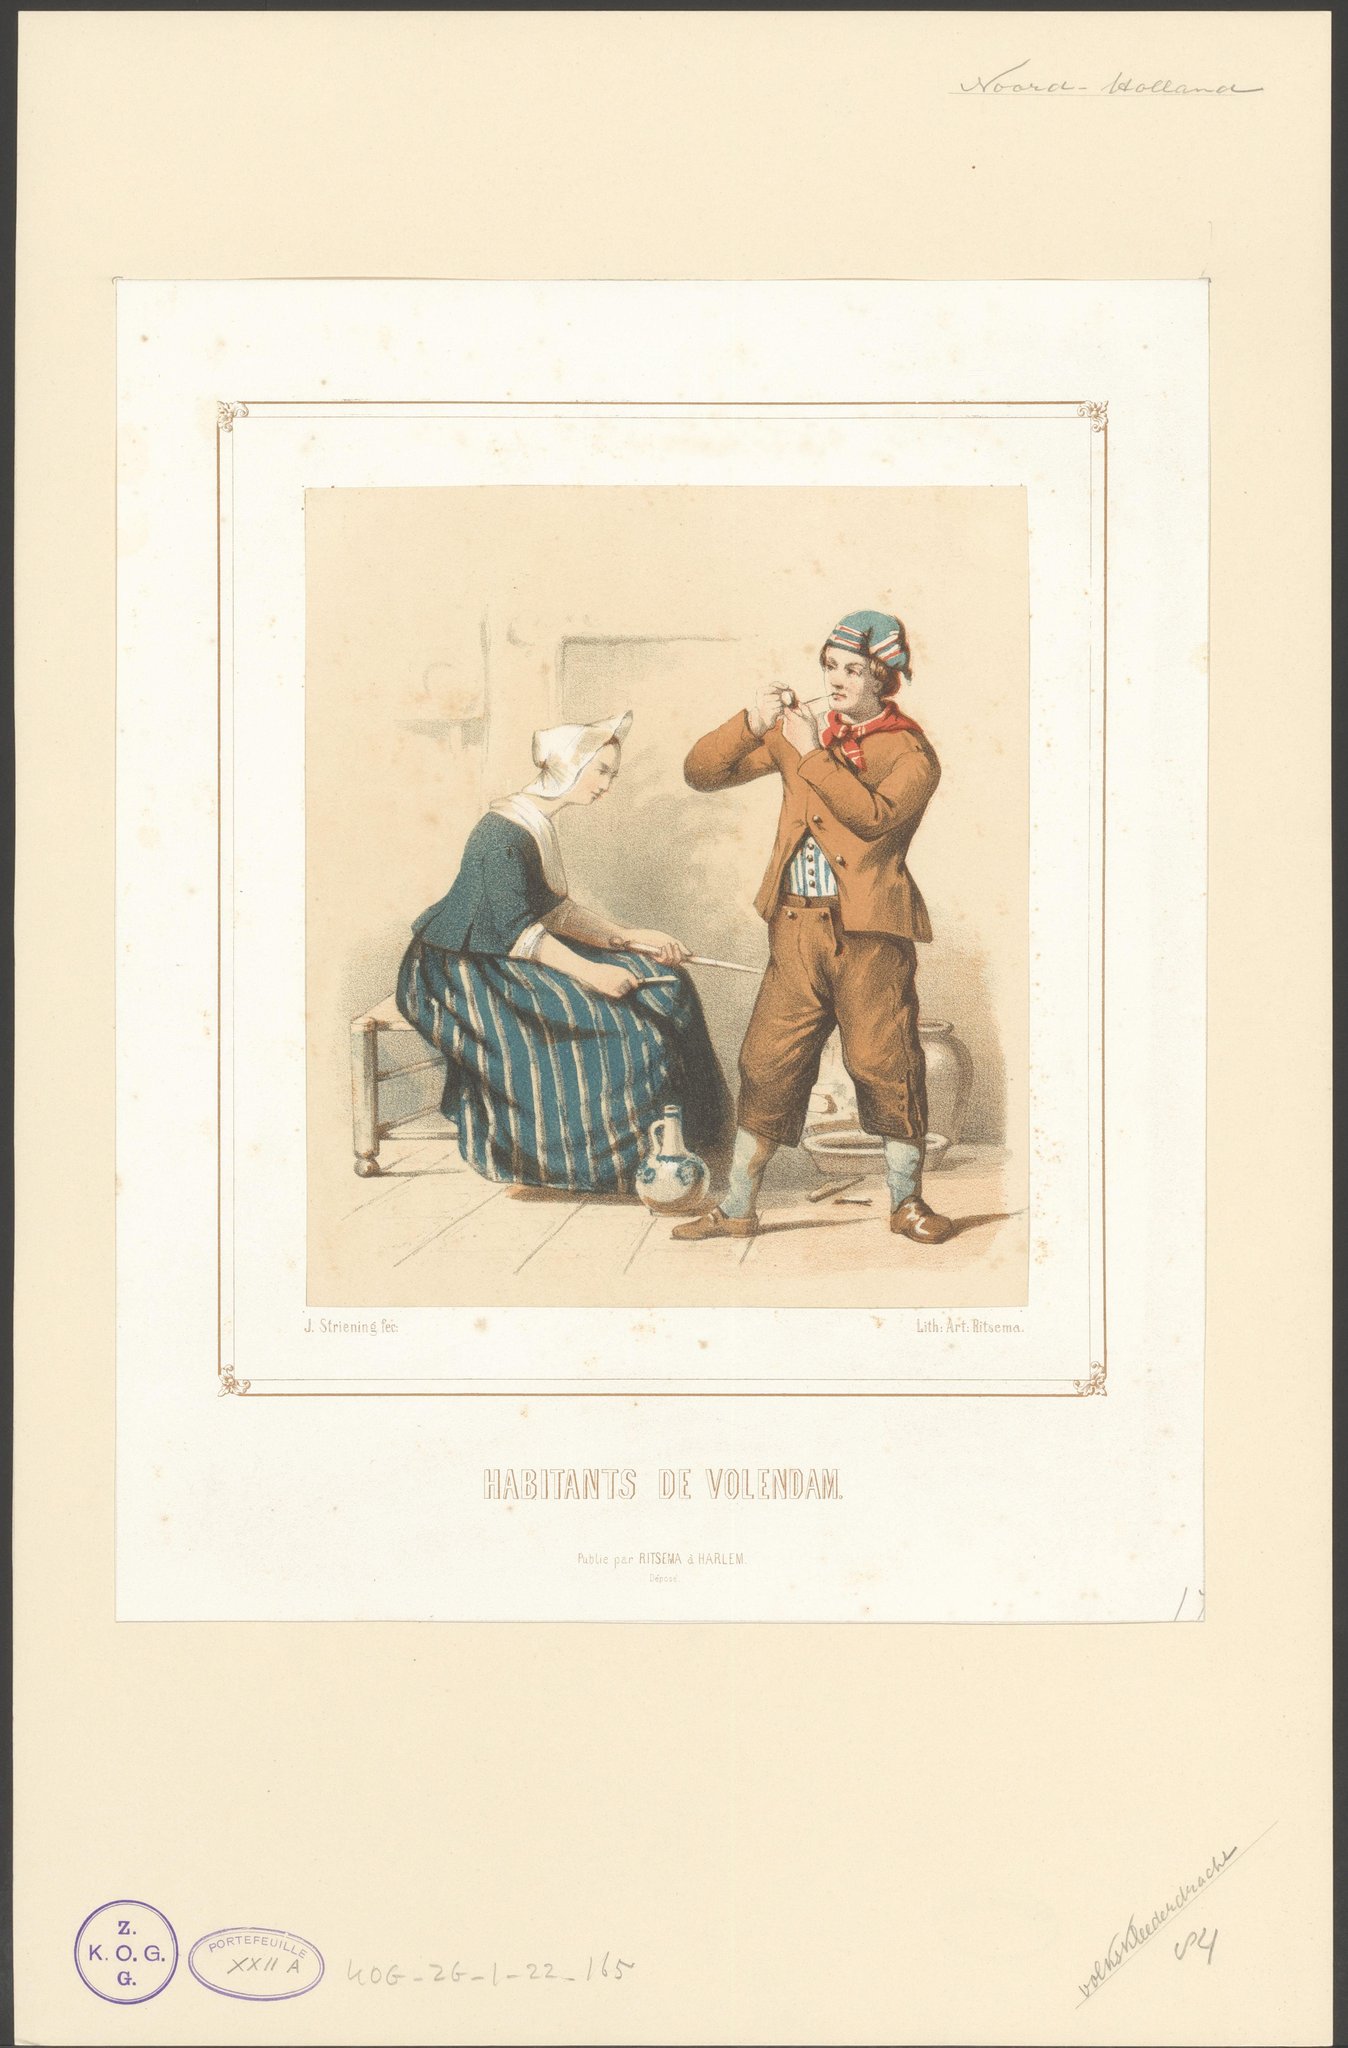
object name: print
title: Inwoners van Volendam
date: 1858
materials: watercolor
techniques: hand coloring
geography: haarlem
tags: clothes, costume (+ women's clothes), clothes, costume (+ men's clothes), folk costume, regional costume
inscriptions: collector's mark, collector's mark: Lugt 1641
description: Waarschijnlijk gebruikt als illustratie in: Costumes nationaux de la Hollande, dessinés d'après nature par J. Striening. Haarlem: Ritsema, 1858.